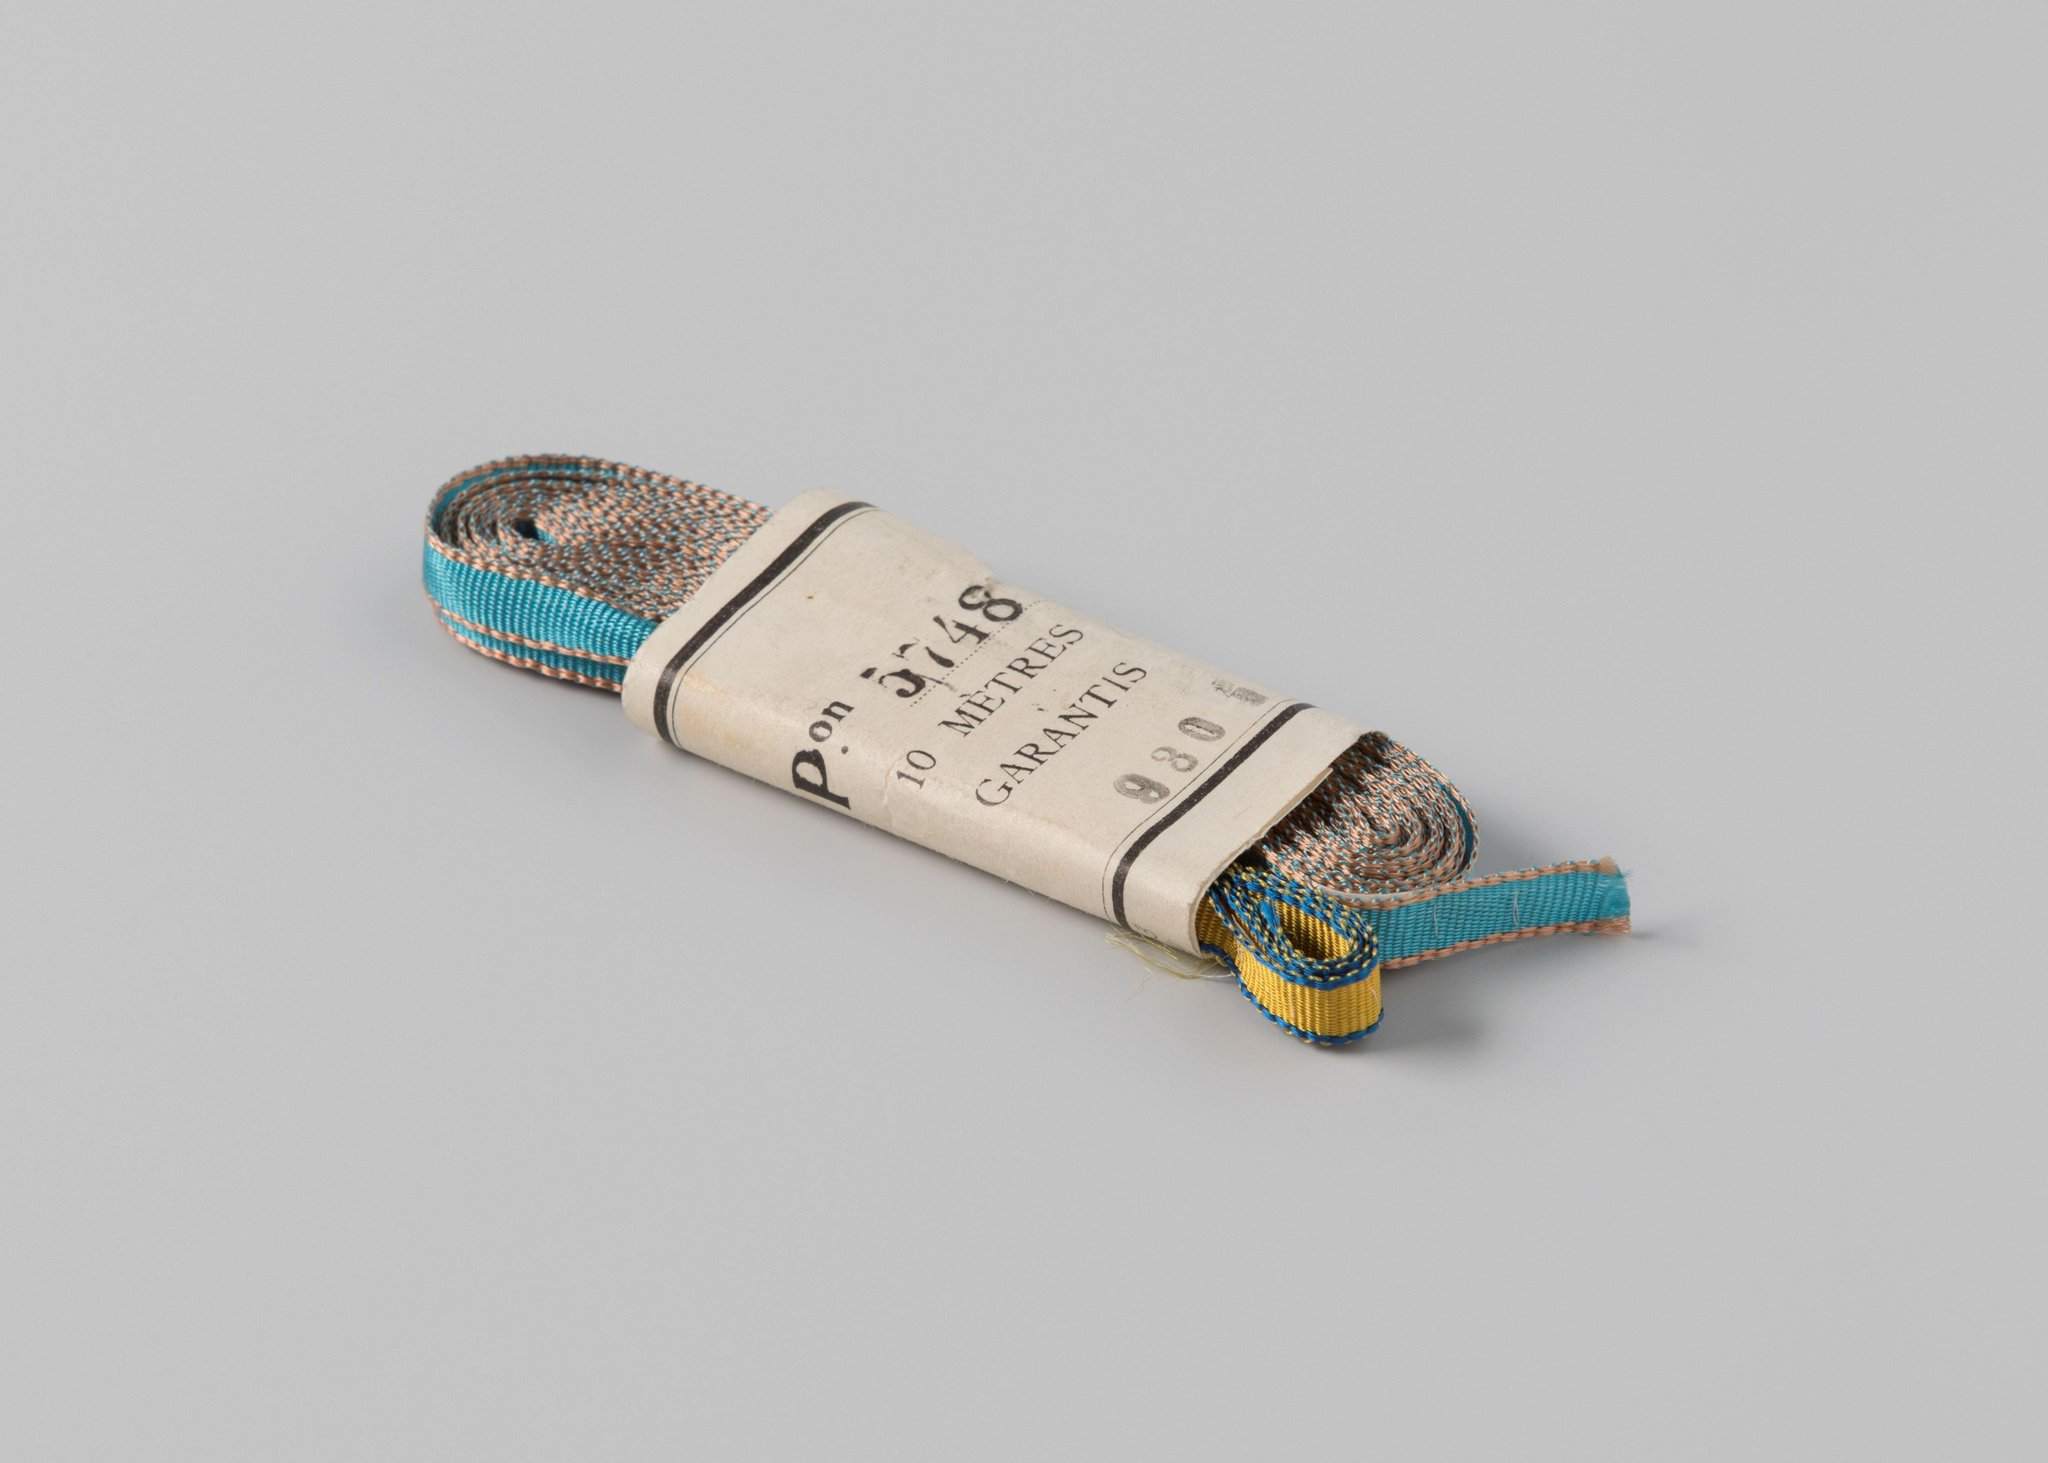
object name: ribbon material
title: Lint, geel aan beide zijden blauw afgebiesd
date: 1890-1935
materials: textile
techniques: weave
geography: nijmegen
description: Lint, geel aan beide zijden blauw afgebiesd.